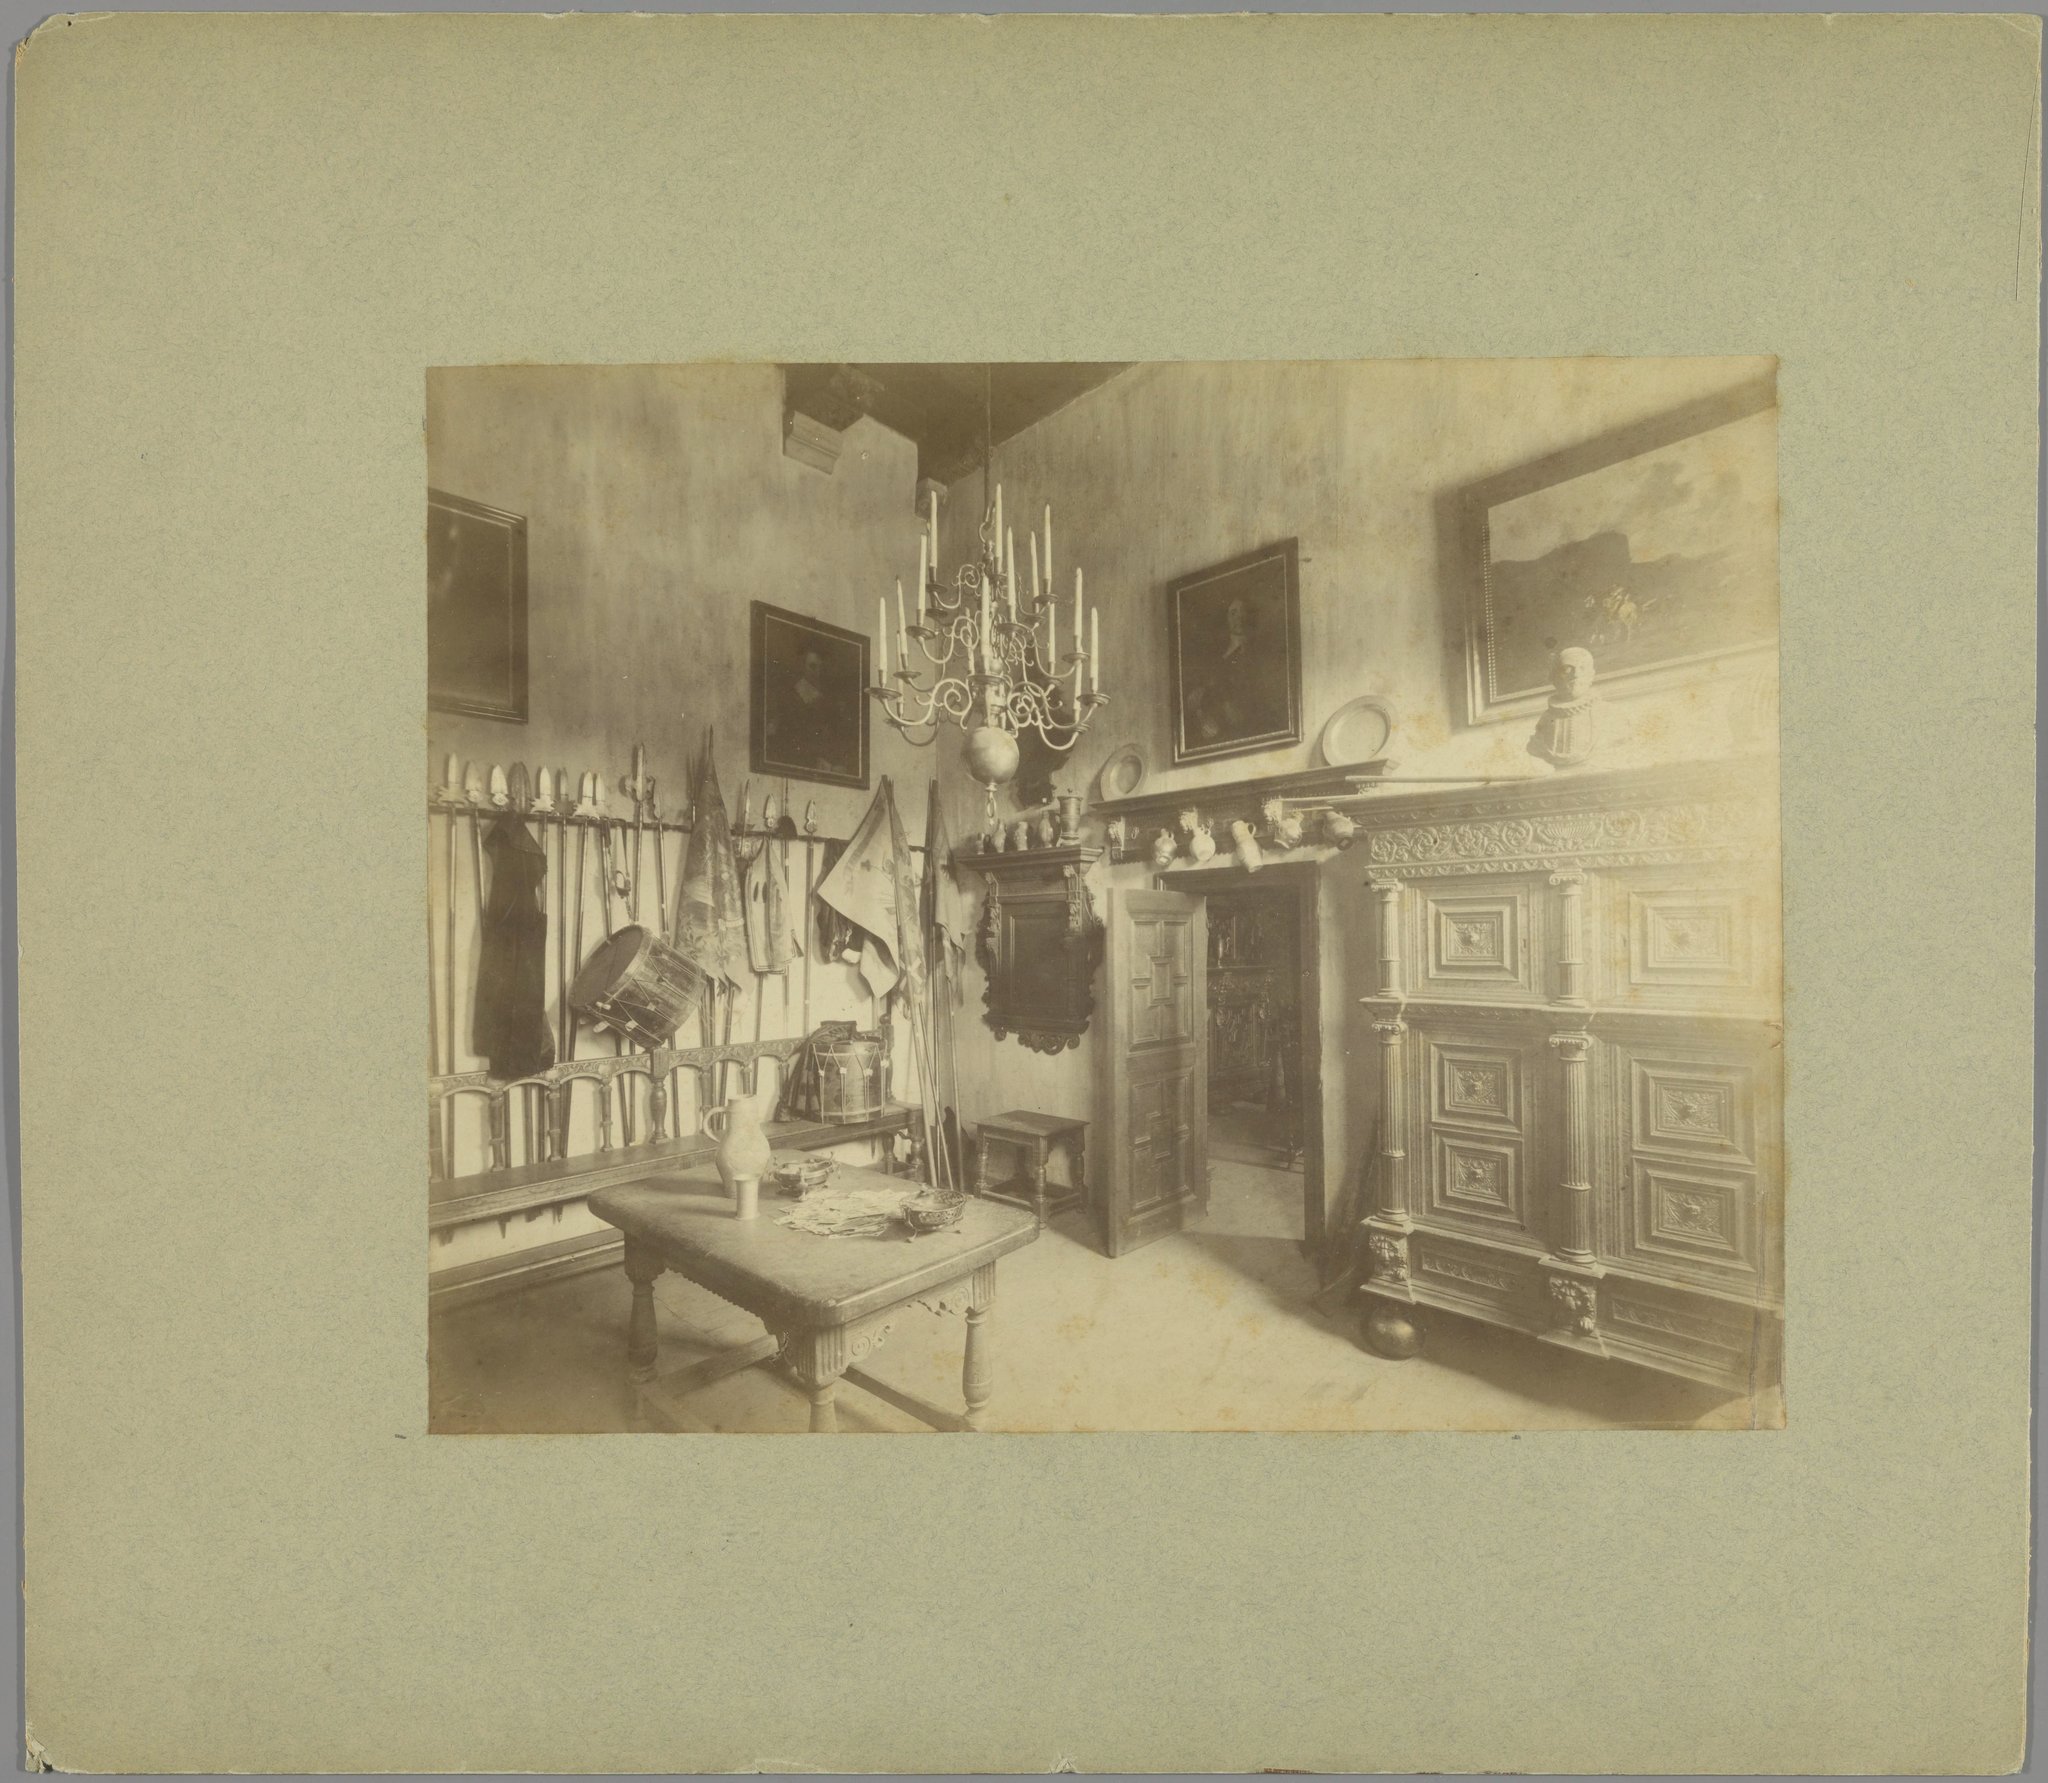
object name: photograph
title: Interieur van de Nationale Tentoonstelling van Oude en Nieuwe Kunstnijverheid in 1888 gehouden op de Koekamp te Den Haag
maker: Anonymous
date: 1888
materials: cardboard, photographic support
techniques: albumen print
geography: the hague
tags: chandelier, candelabrum, casting weapons: spear, temporary exhibition, 'salon', the hague